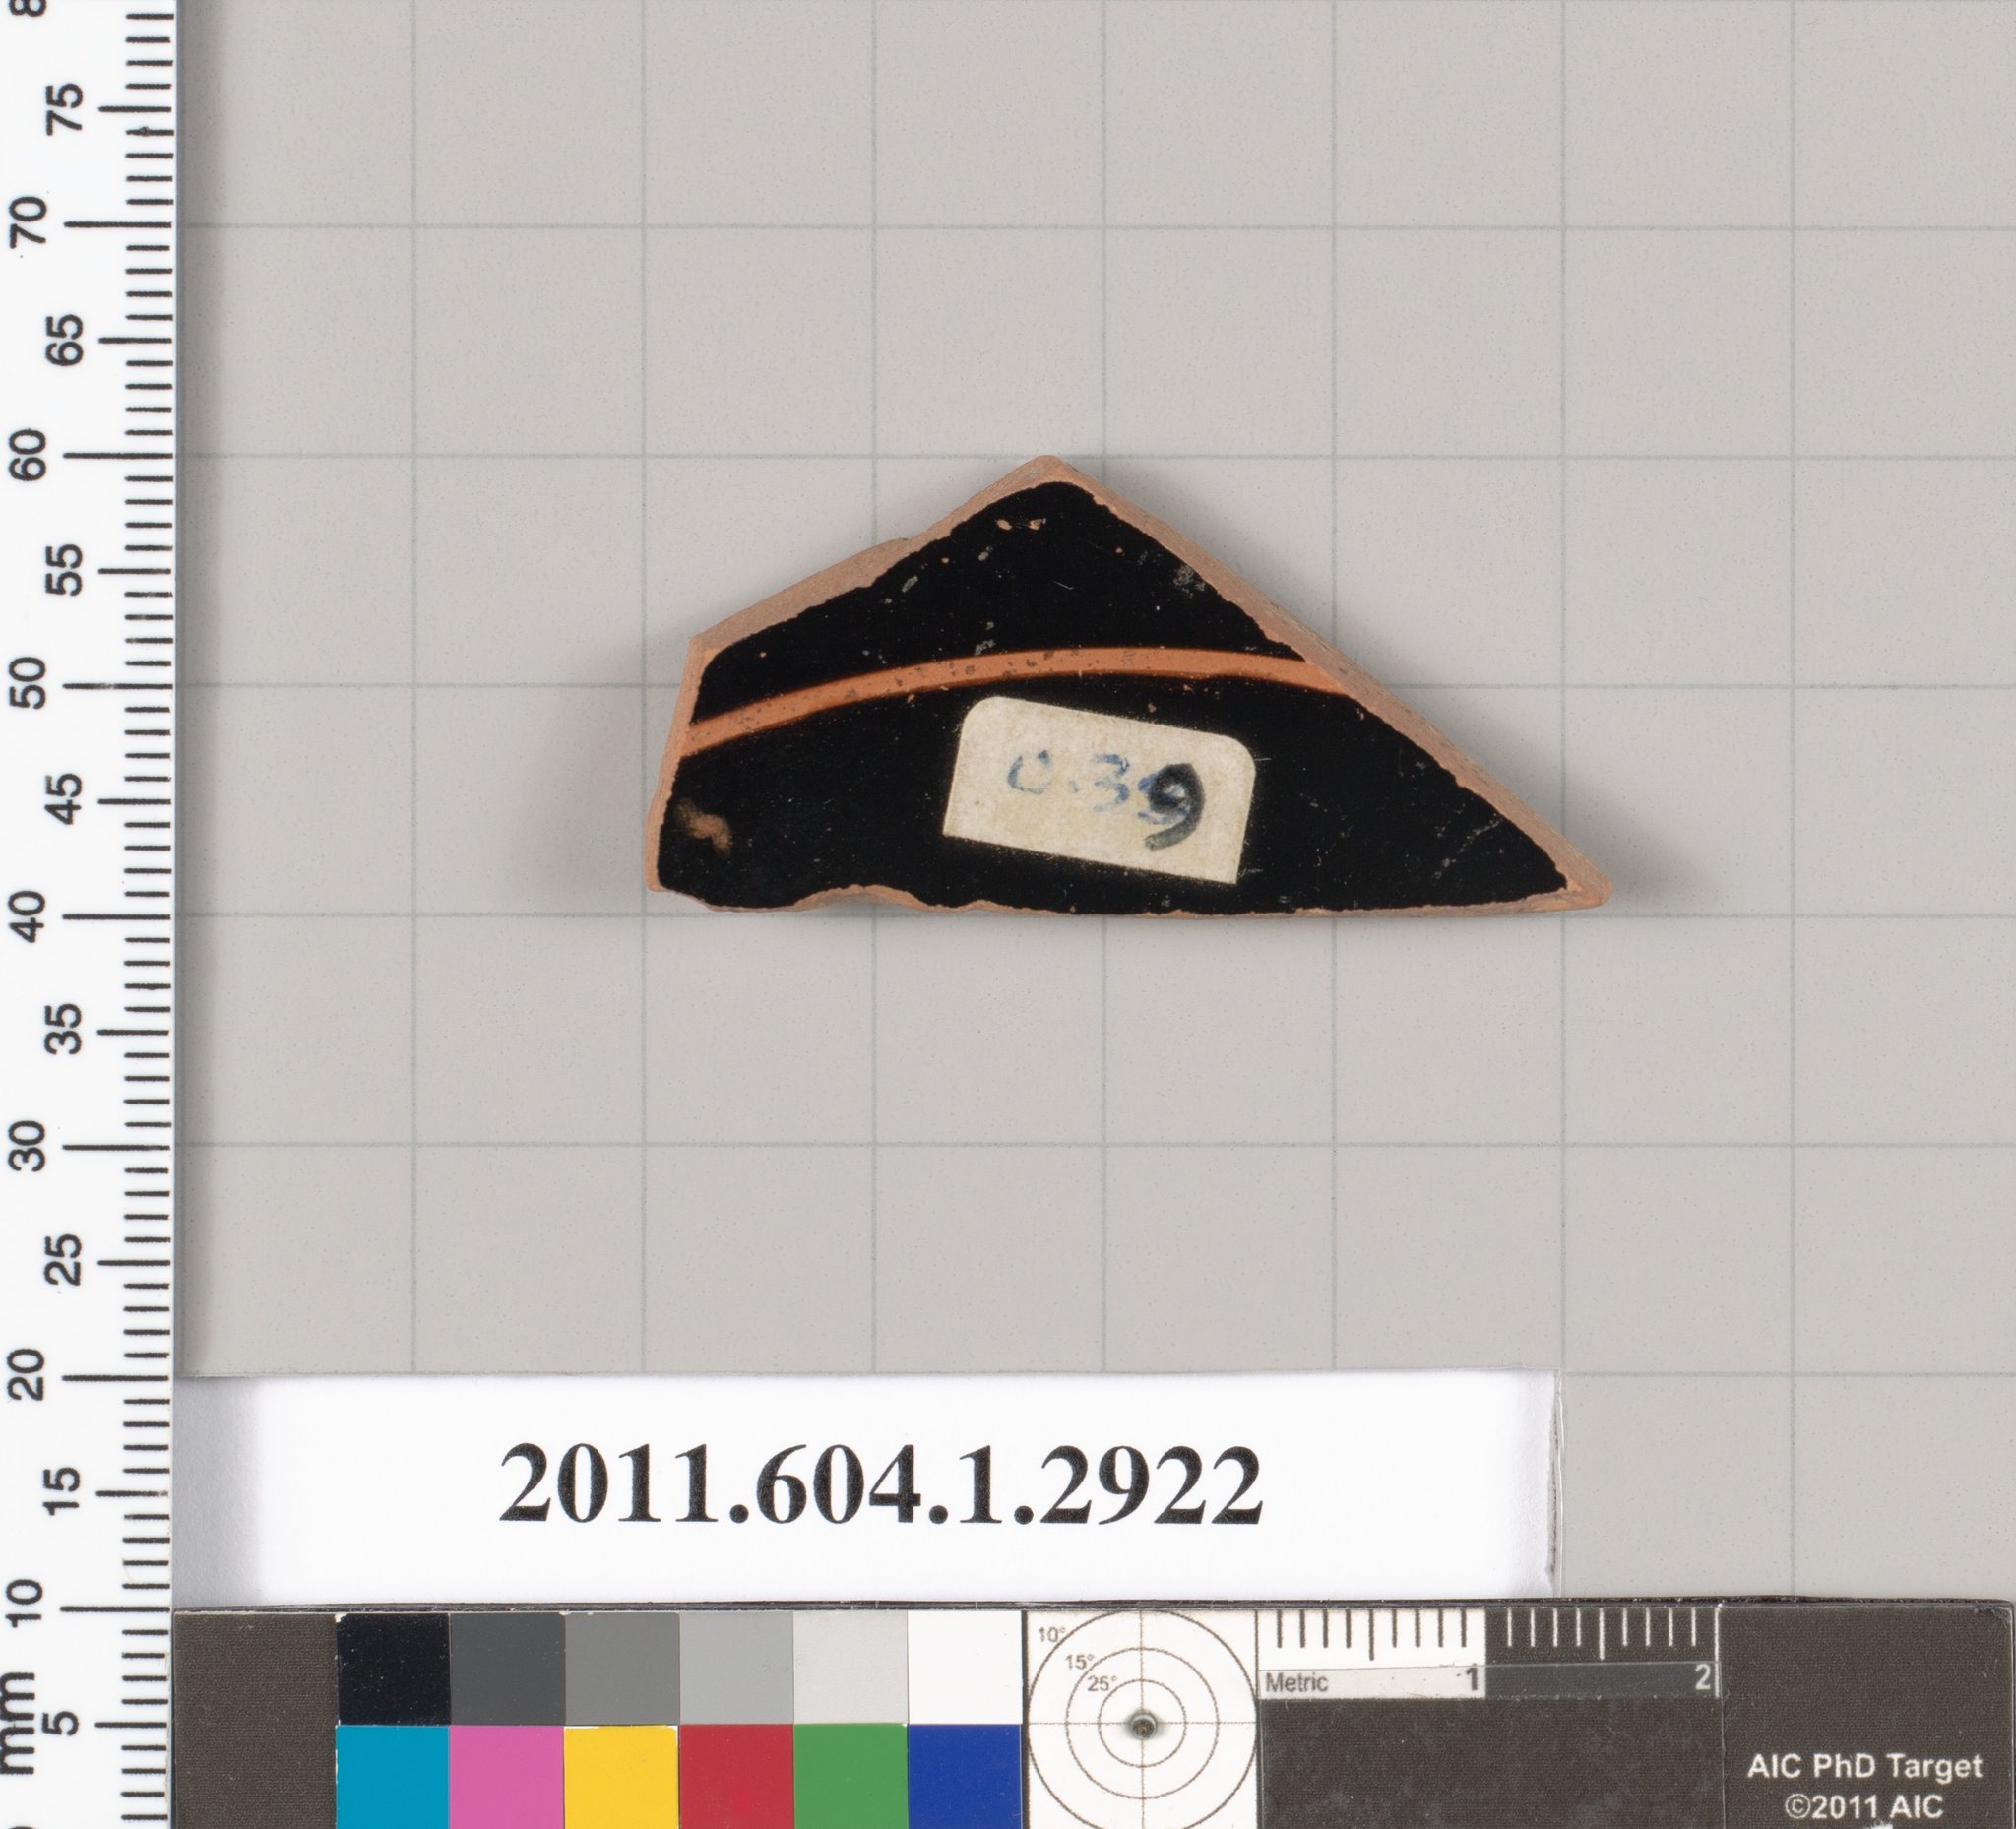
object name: kylix fragment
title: Terracotta fragment of a kylix (drinking cup)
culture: greek, attic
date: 600-401 BCE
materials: terracotta